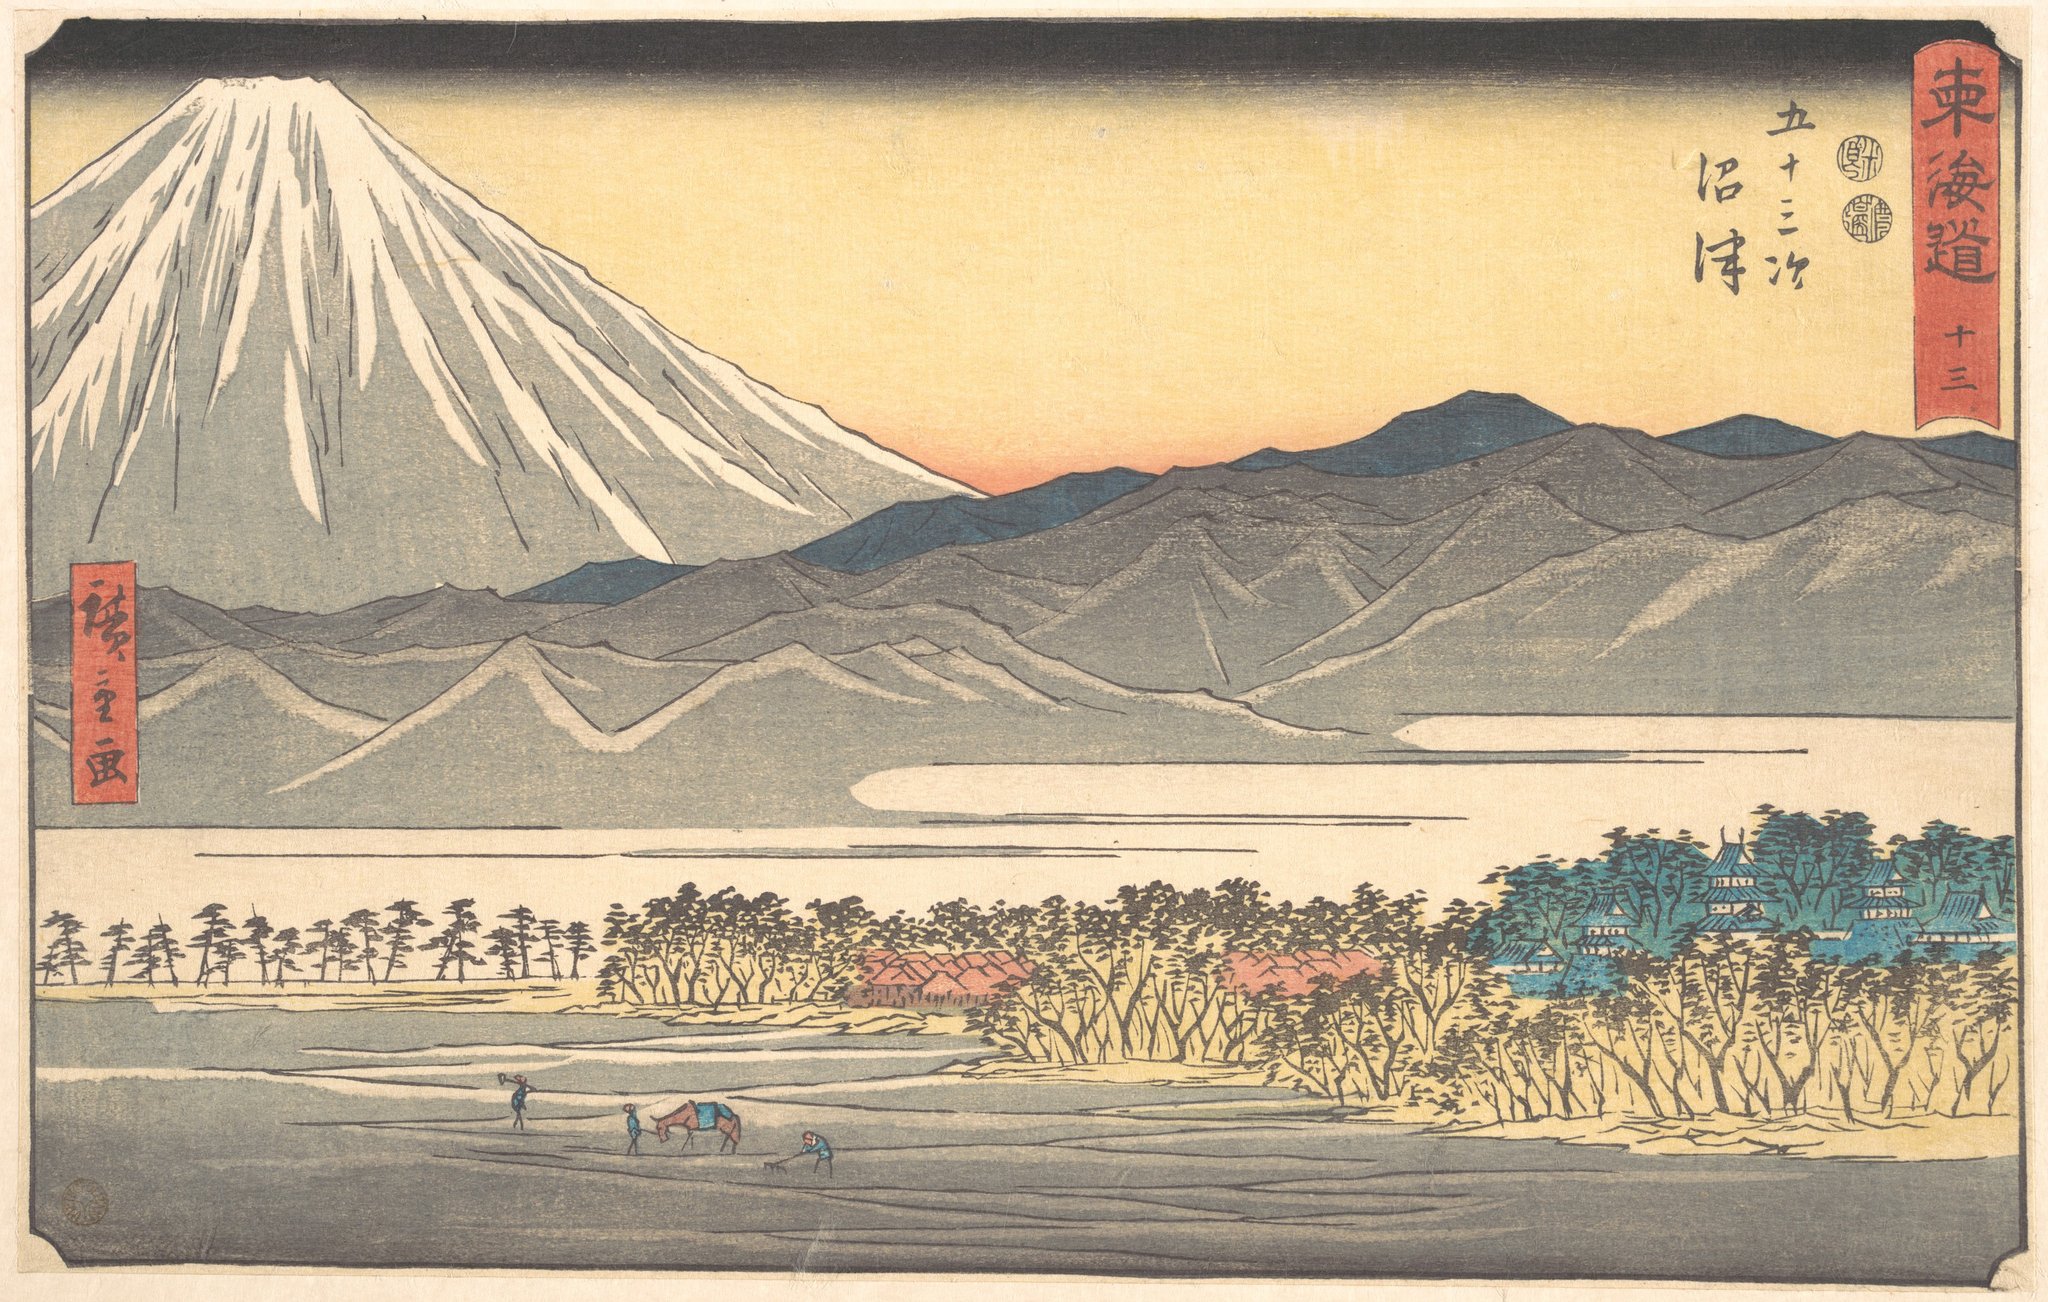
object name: print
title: Numazu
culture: japanese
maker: utagawa hiroshige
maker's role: artist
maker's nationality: japanese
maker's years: 1797-1858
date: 1840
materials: ink, paper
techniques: woodblock print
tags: human figures,animals,mountains,landscapes,trees